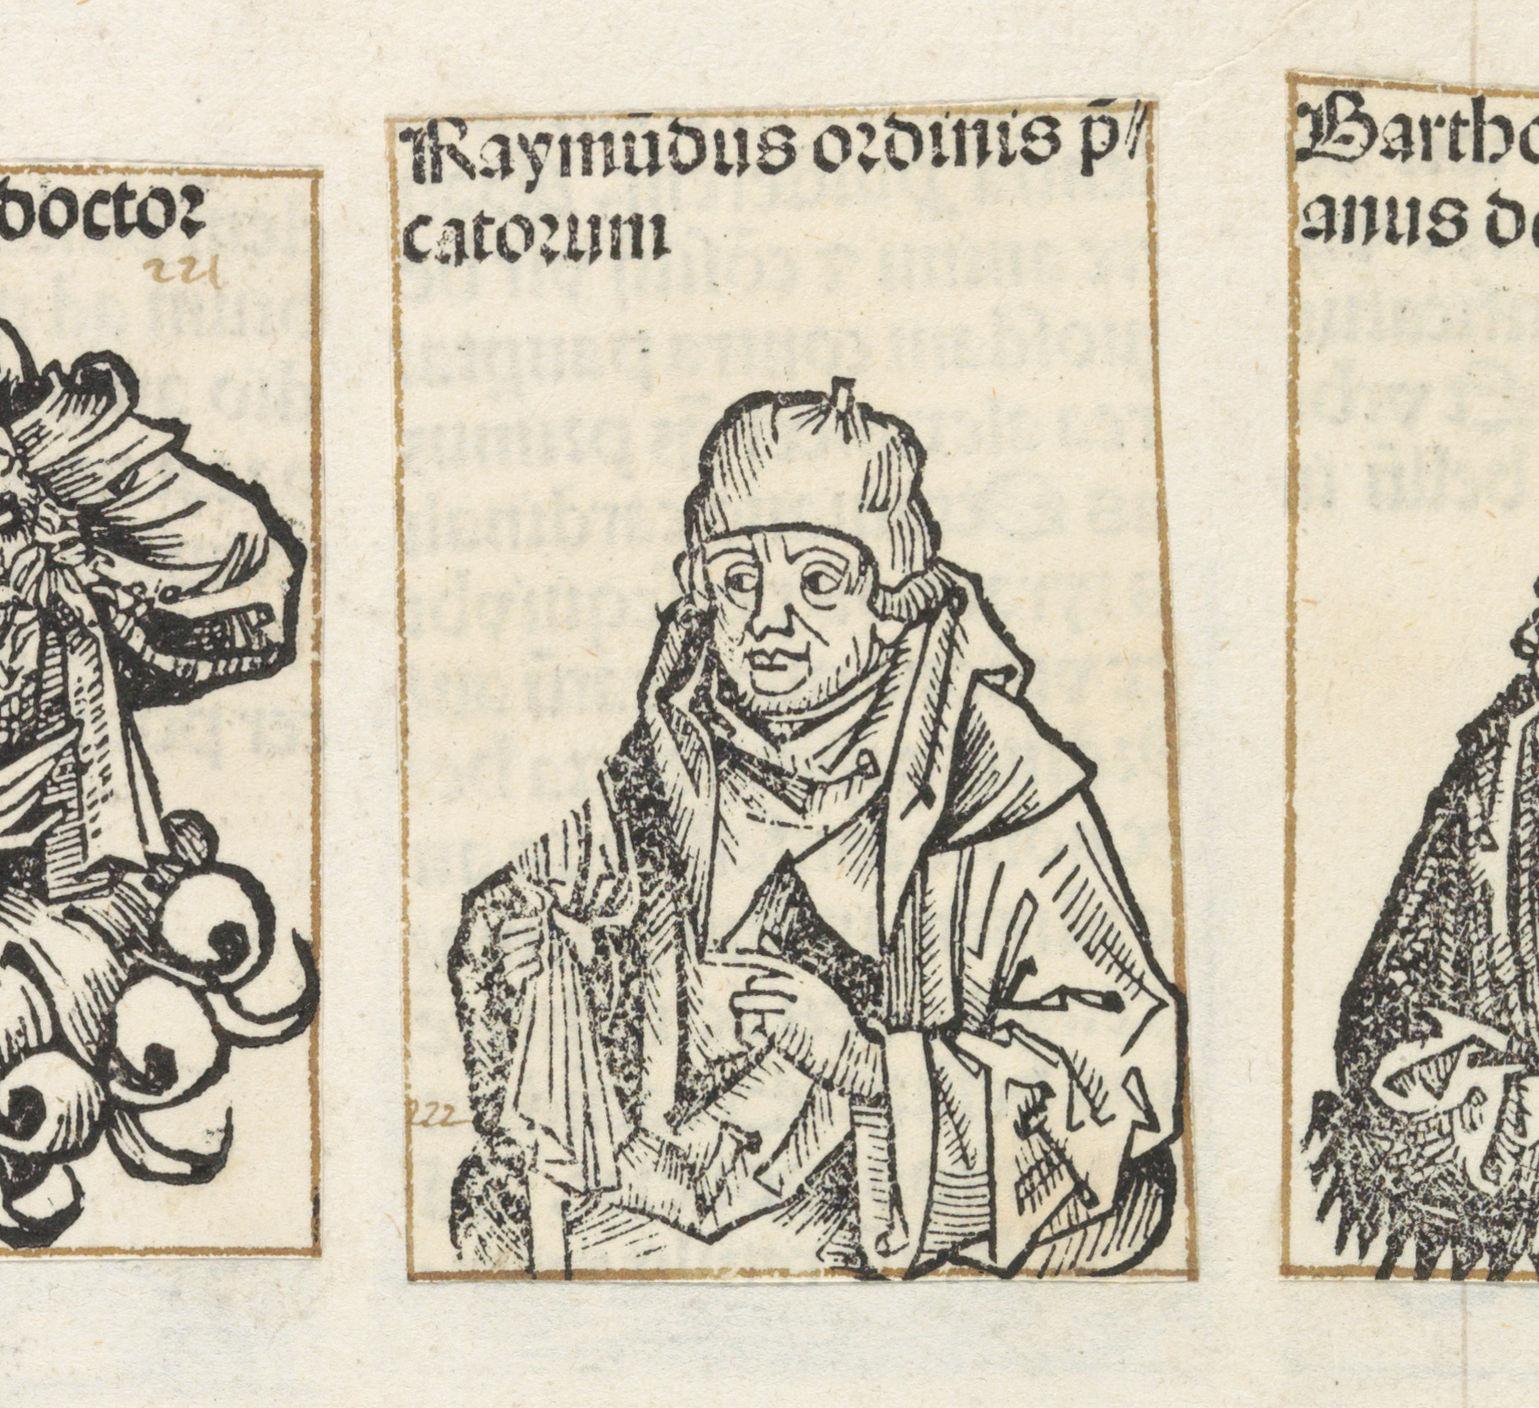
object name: album leaf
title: Raymu[n]dus ordinis p[raedi]catorum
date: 1493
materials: paper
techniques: letterpress printing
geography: nuremberg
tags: monk(s), friar(s)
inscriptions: inscription: ‘222’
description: De houtsnede wordt herhaaldelijk gebruikt als boekillustratie in de Liber Chronicarum (of Neurenbergkroniek) van Hartmann Schedel, verschenen in het Latijn en Duits in 1493. Zie de Latijnse uitgave, folio 211r.